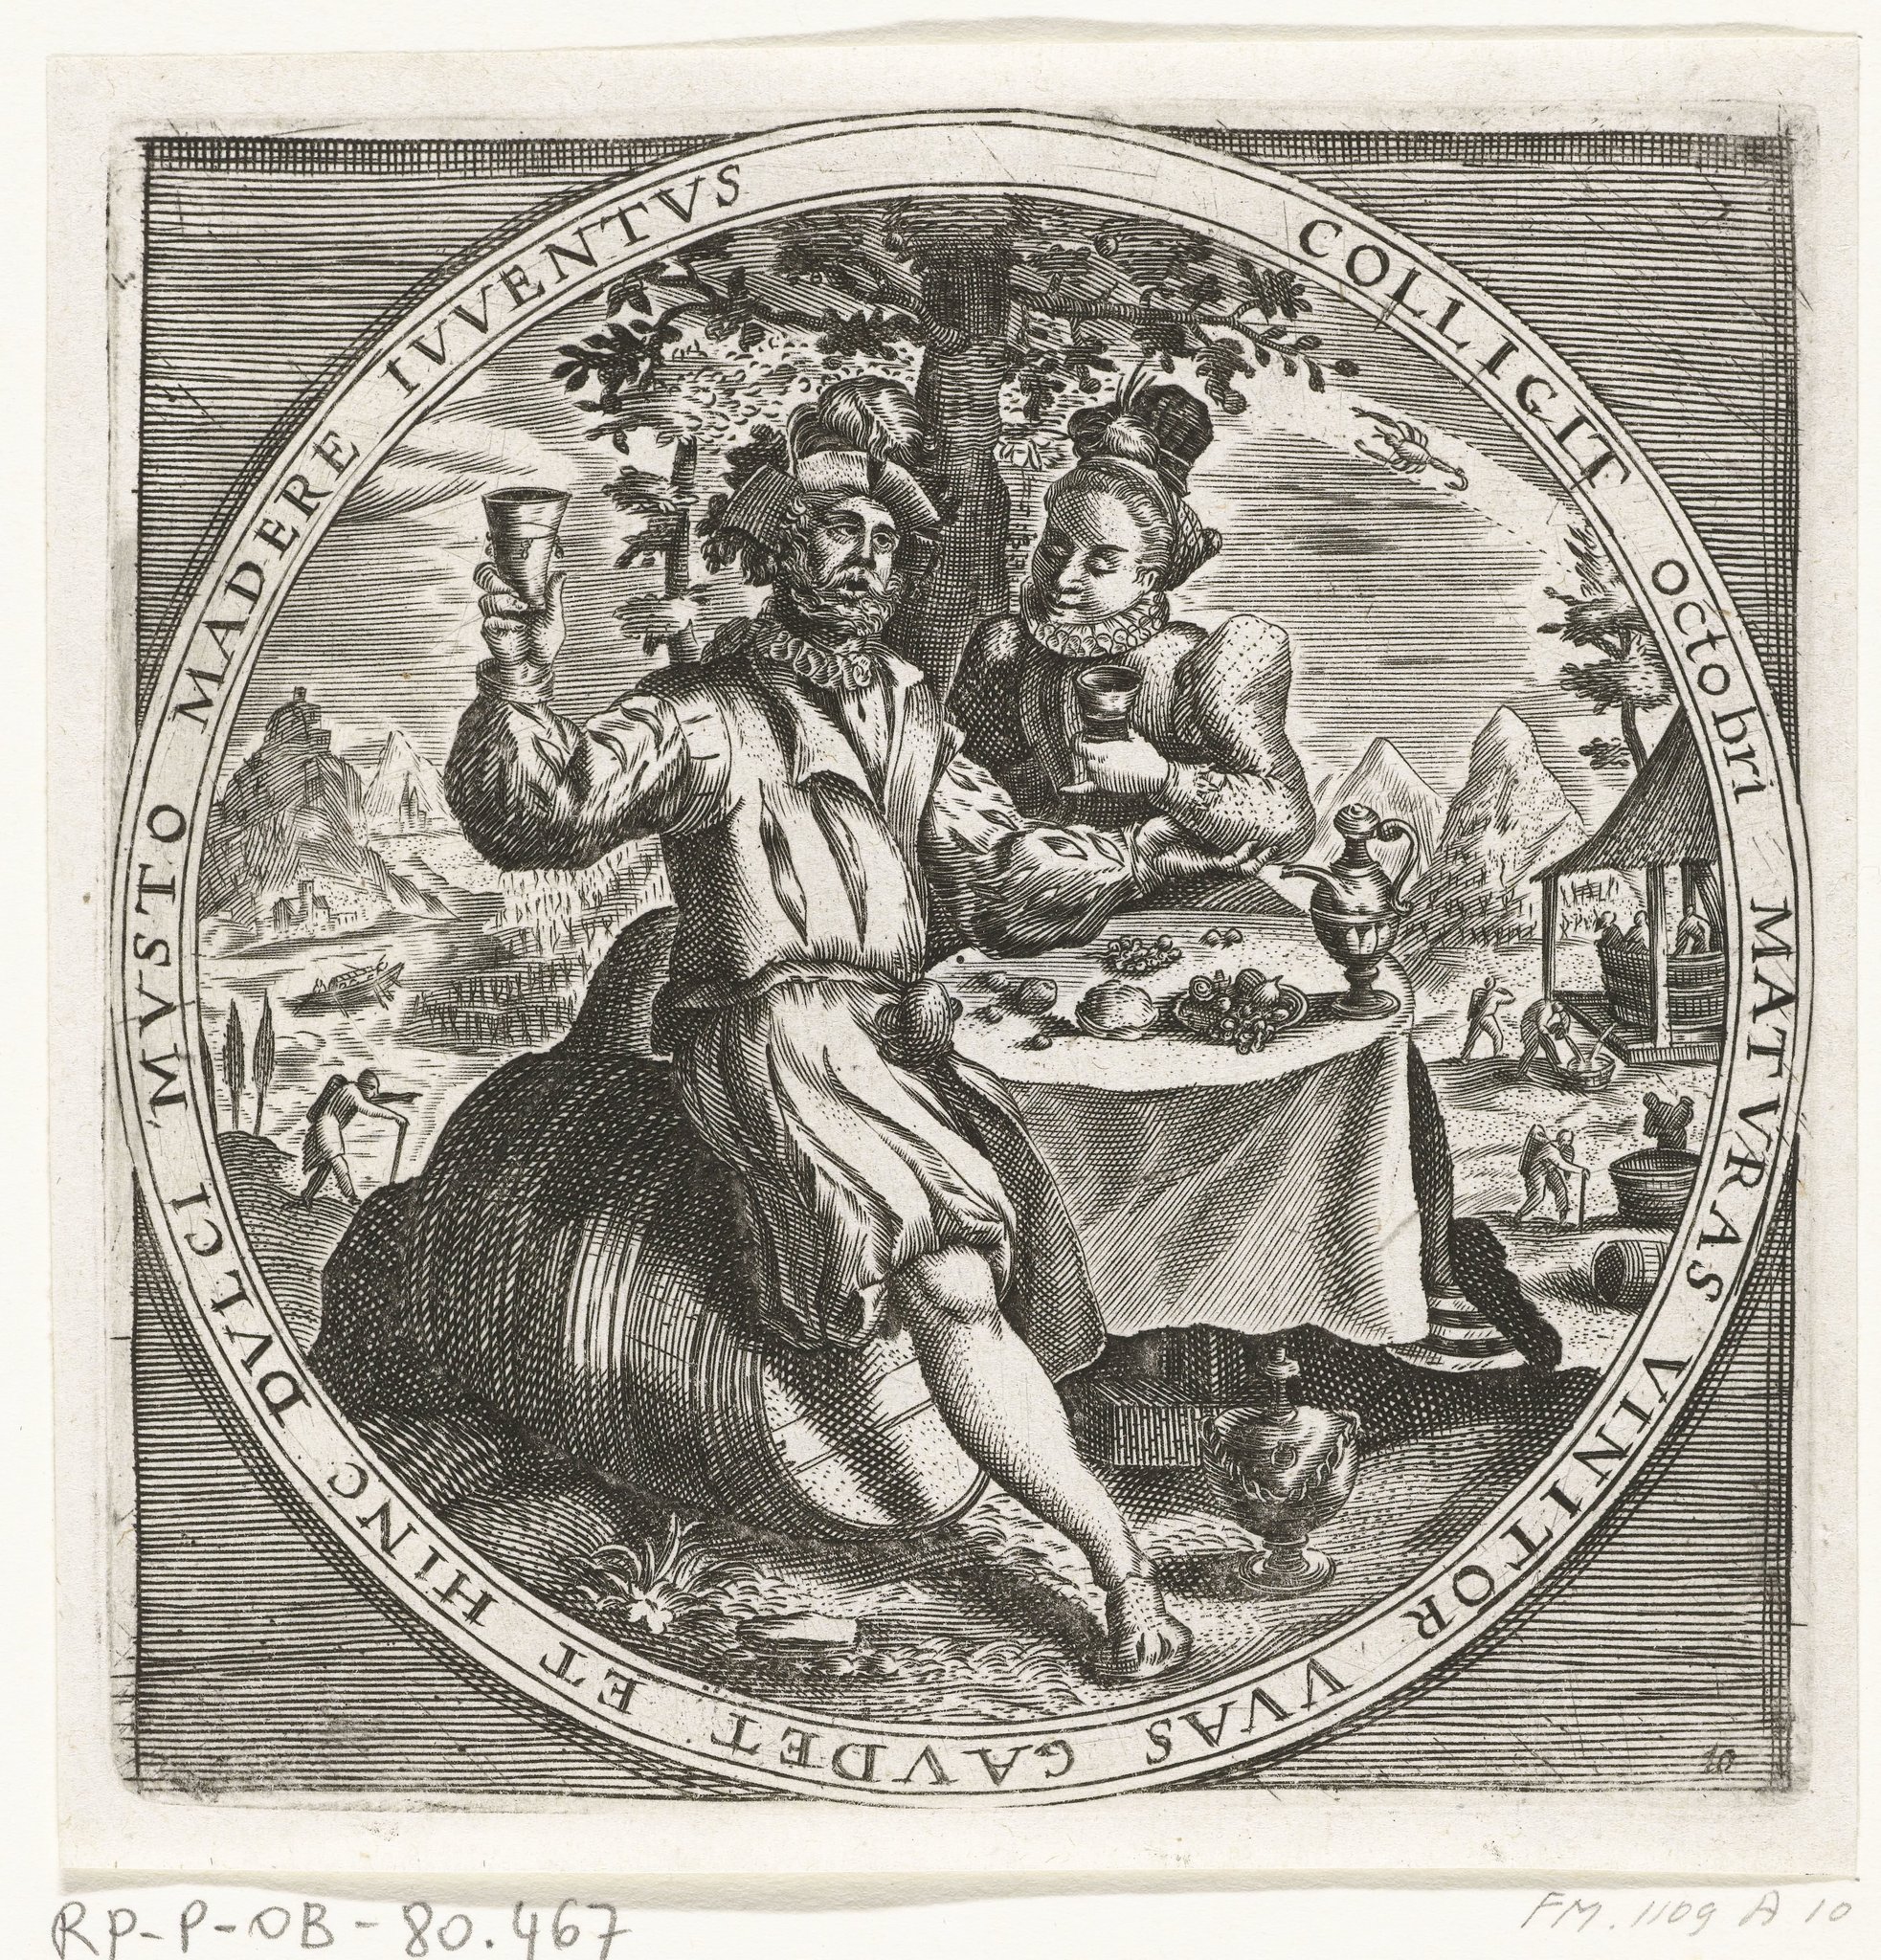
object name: print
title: De twaalf maanden van het jaar verbeeld in scènes uit het volksleven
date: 1600-1649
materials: paper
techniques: engraving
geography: low countries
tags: october and its 'labours', wine production, scorpio (zodiacal sign of october), drinking, low countries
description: Ronde voorstelling met de maand oktober. Een man en vrouw drinken wijn gezeten aan een tafel, de man zit op een wijnvat. Rechts op de achtergrond wordt wijn gemaakt, ca. 1600. Met het teken van de Schorpioen. Met randschrift in het Latijn. Prent nr. 10 in de serie van de twaalf maanden van het jaar verbeeld in scènes uit het volksleven.